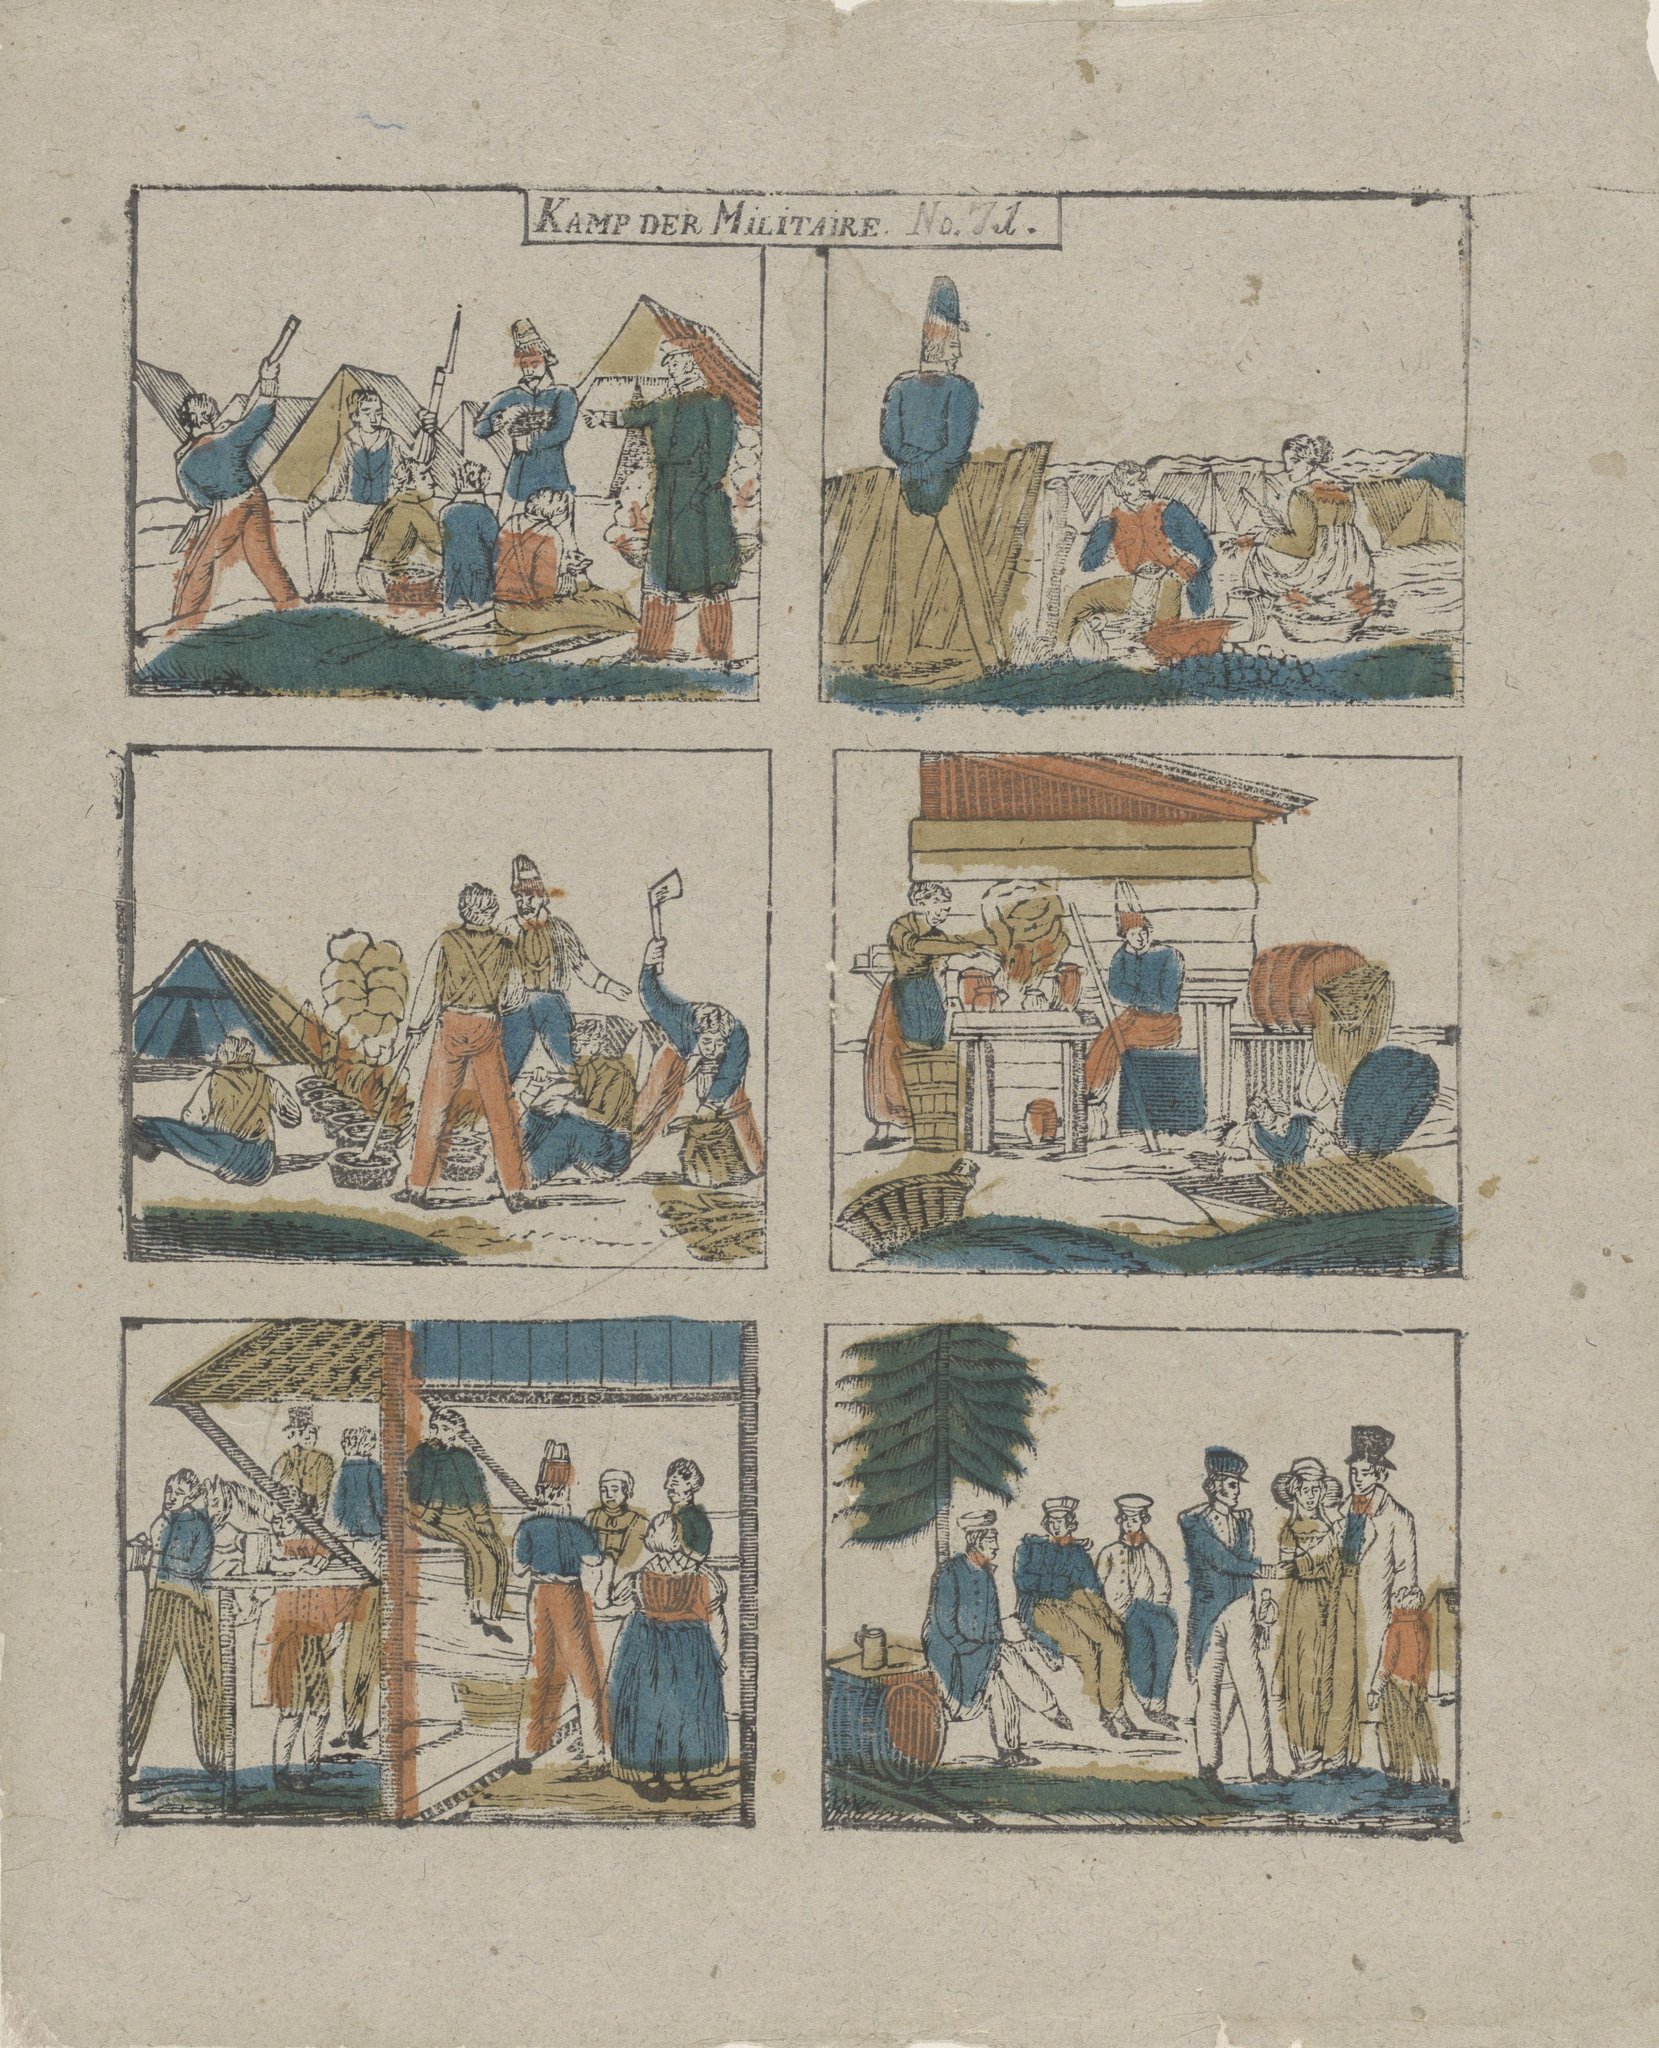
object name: popular print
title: Kamp der militaire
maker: Anonymous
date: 1700-1899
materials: paper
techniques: colour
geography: netherlands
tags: (military) camp with tents, the soldier; the soldier's life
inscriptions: collector's mark: Lugt 2760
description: Blad met 6 voorstellingen van militairen in een kamp. Genummerd midden boven: No. 71.